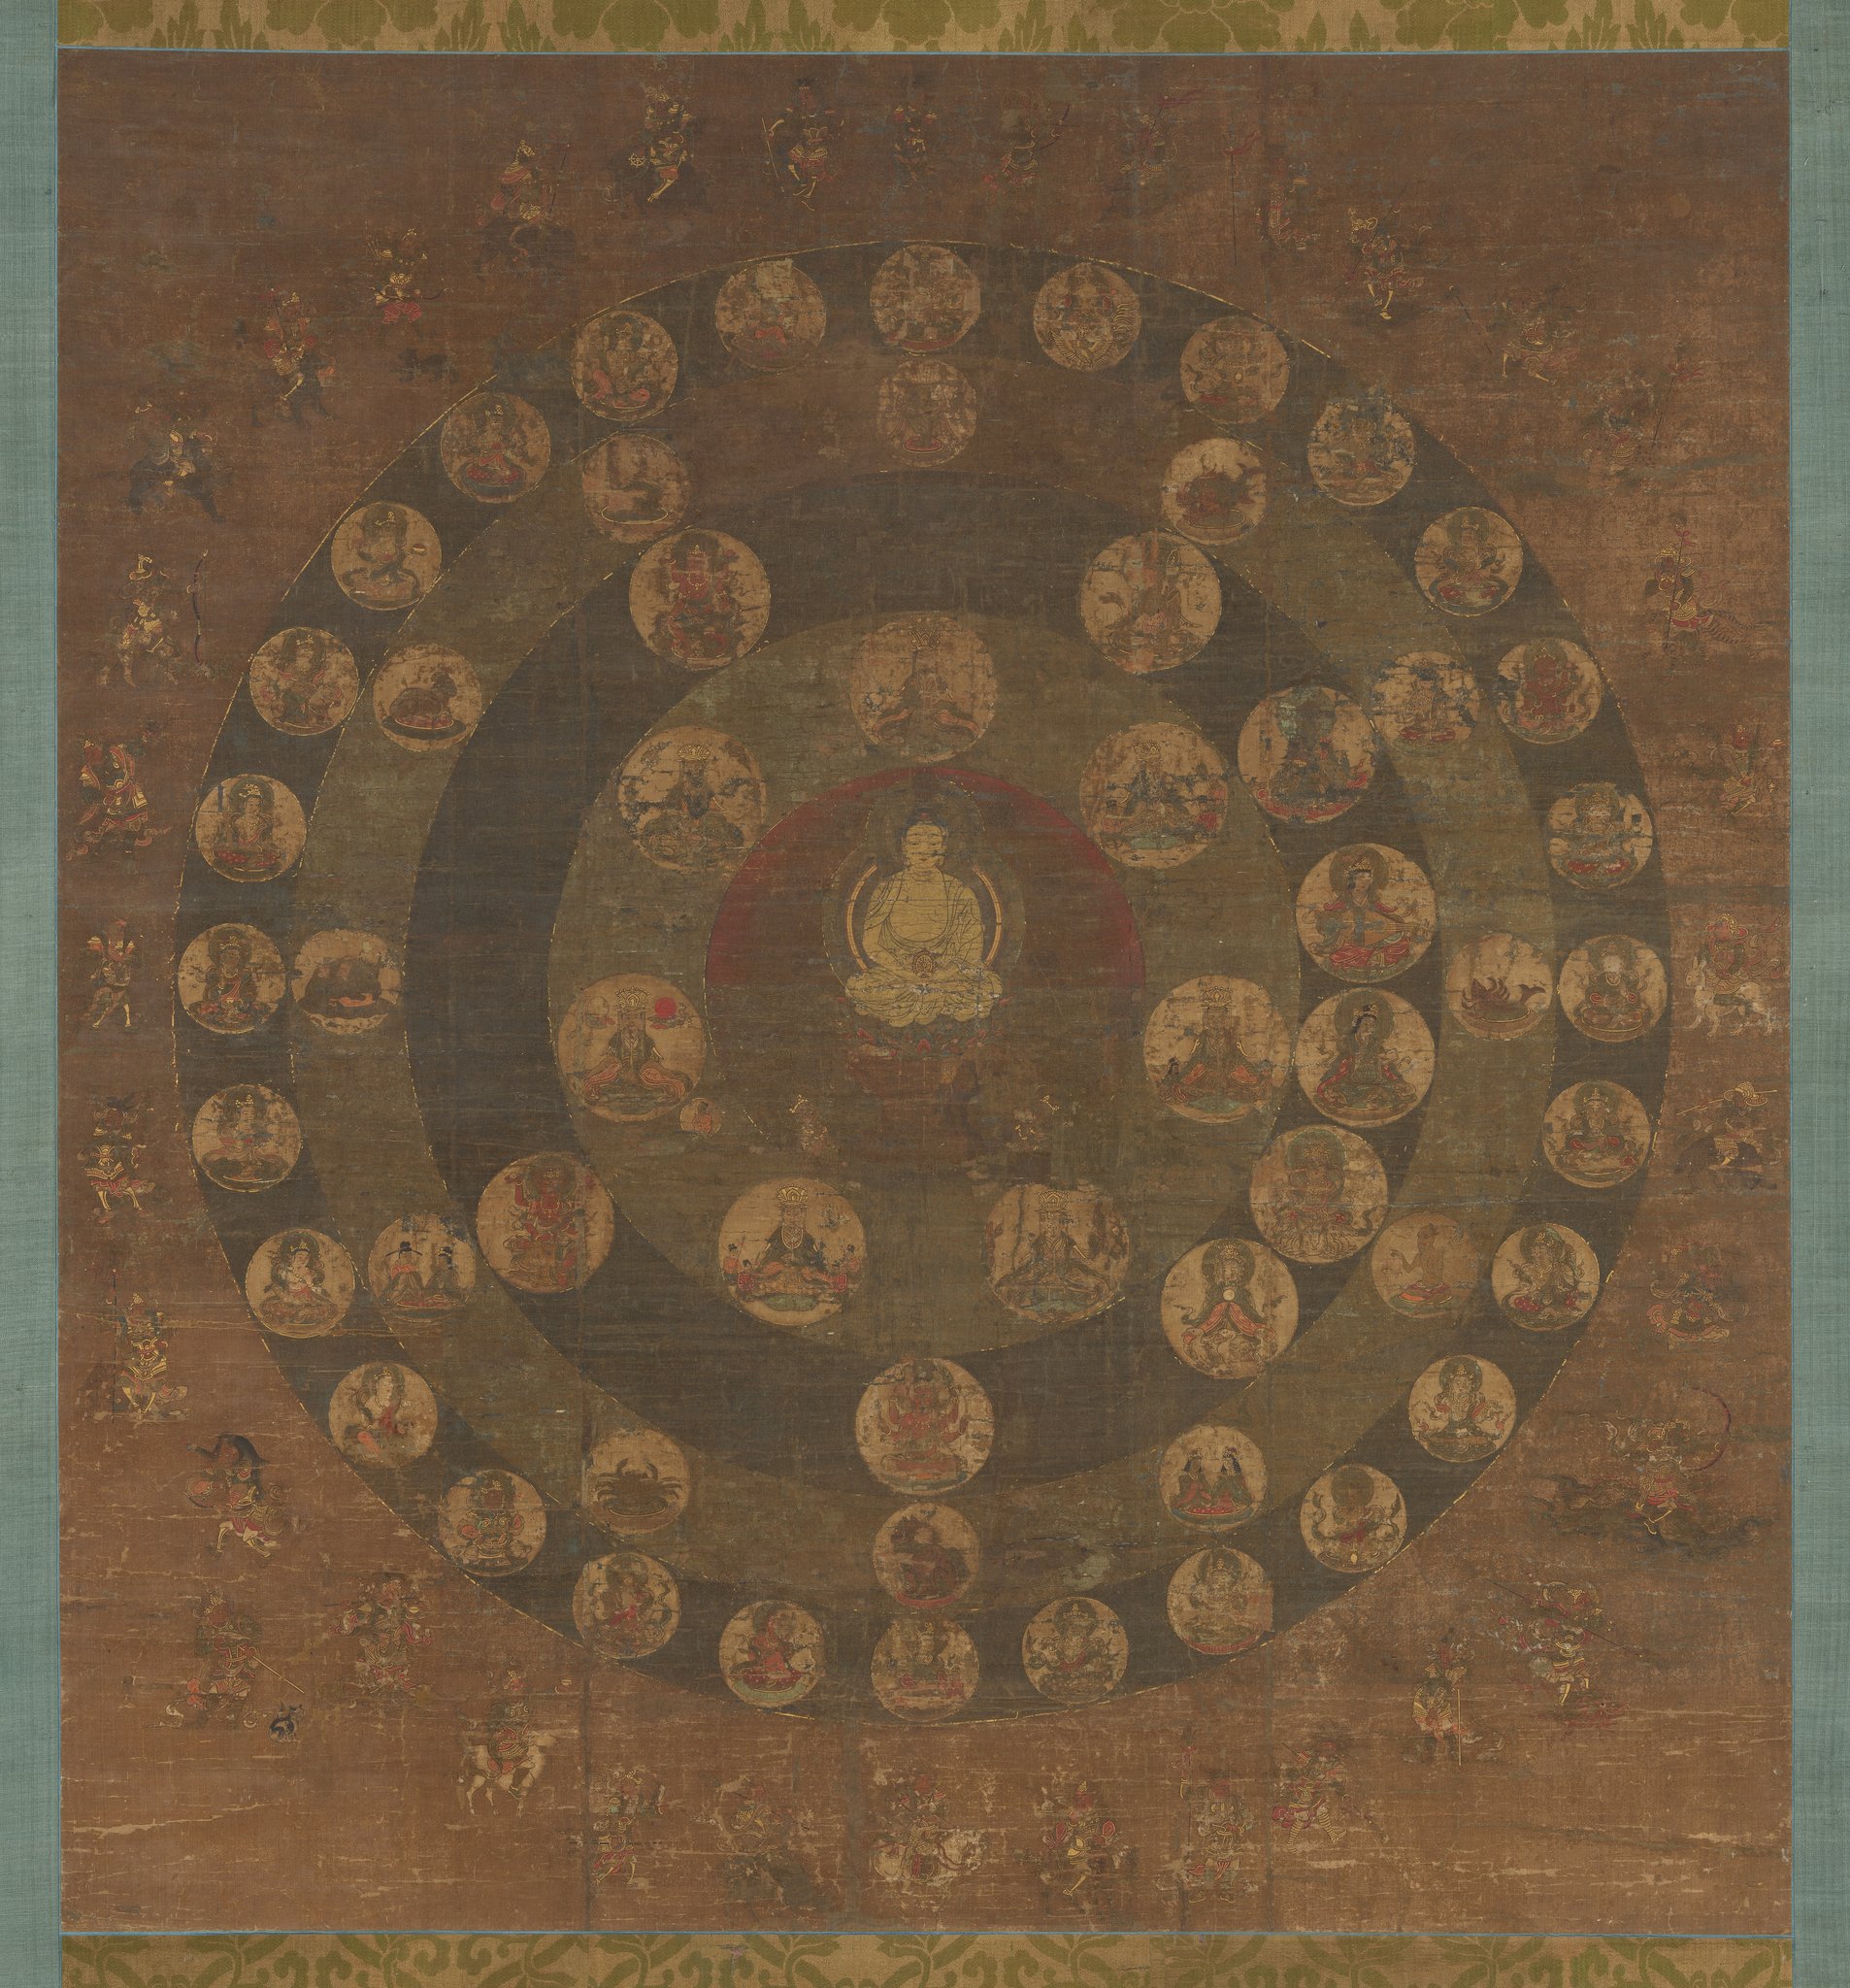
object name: hanging scroll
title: Star Mandala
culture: japanese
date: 1201-1400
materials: gold, ink, silk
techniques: cutting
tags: buddhism,buddha